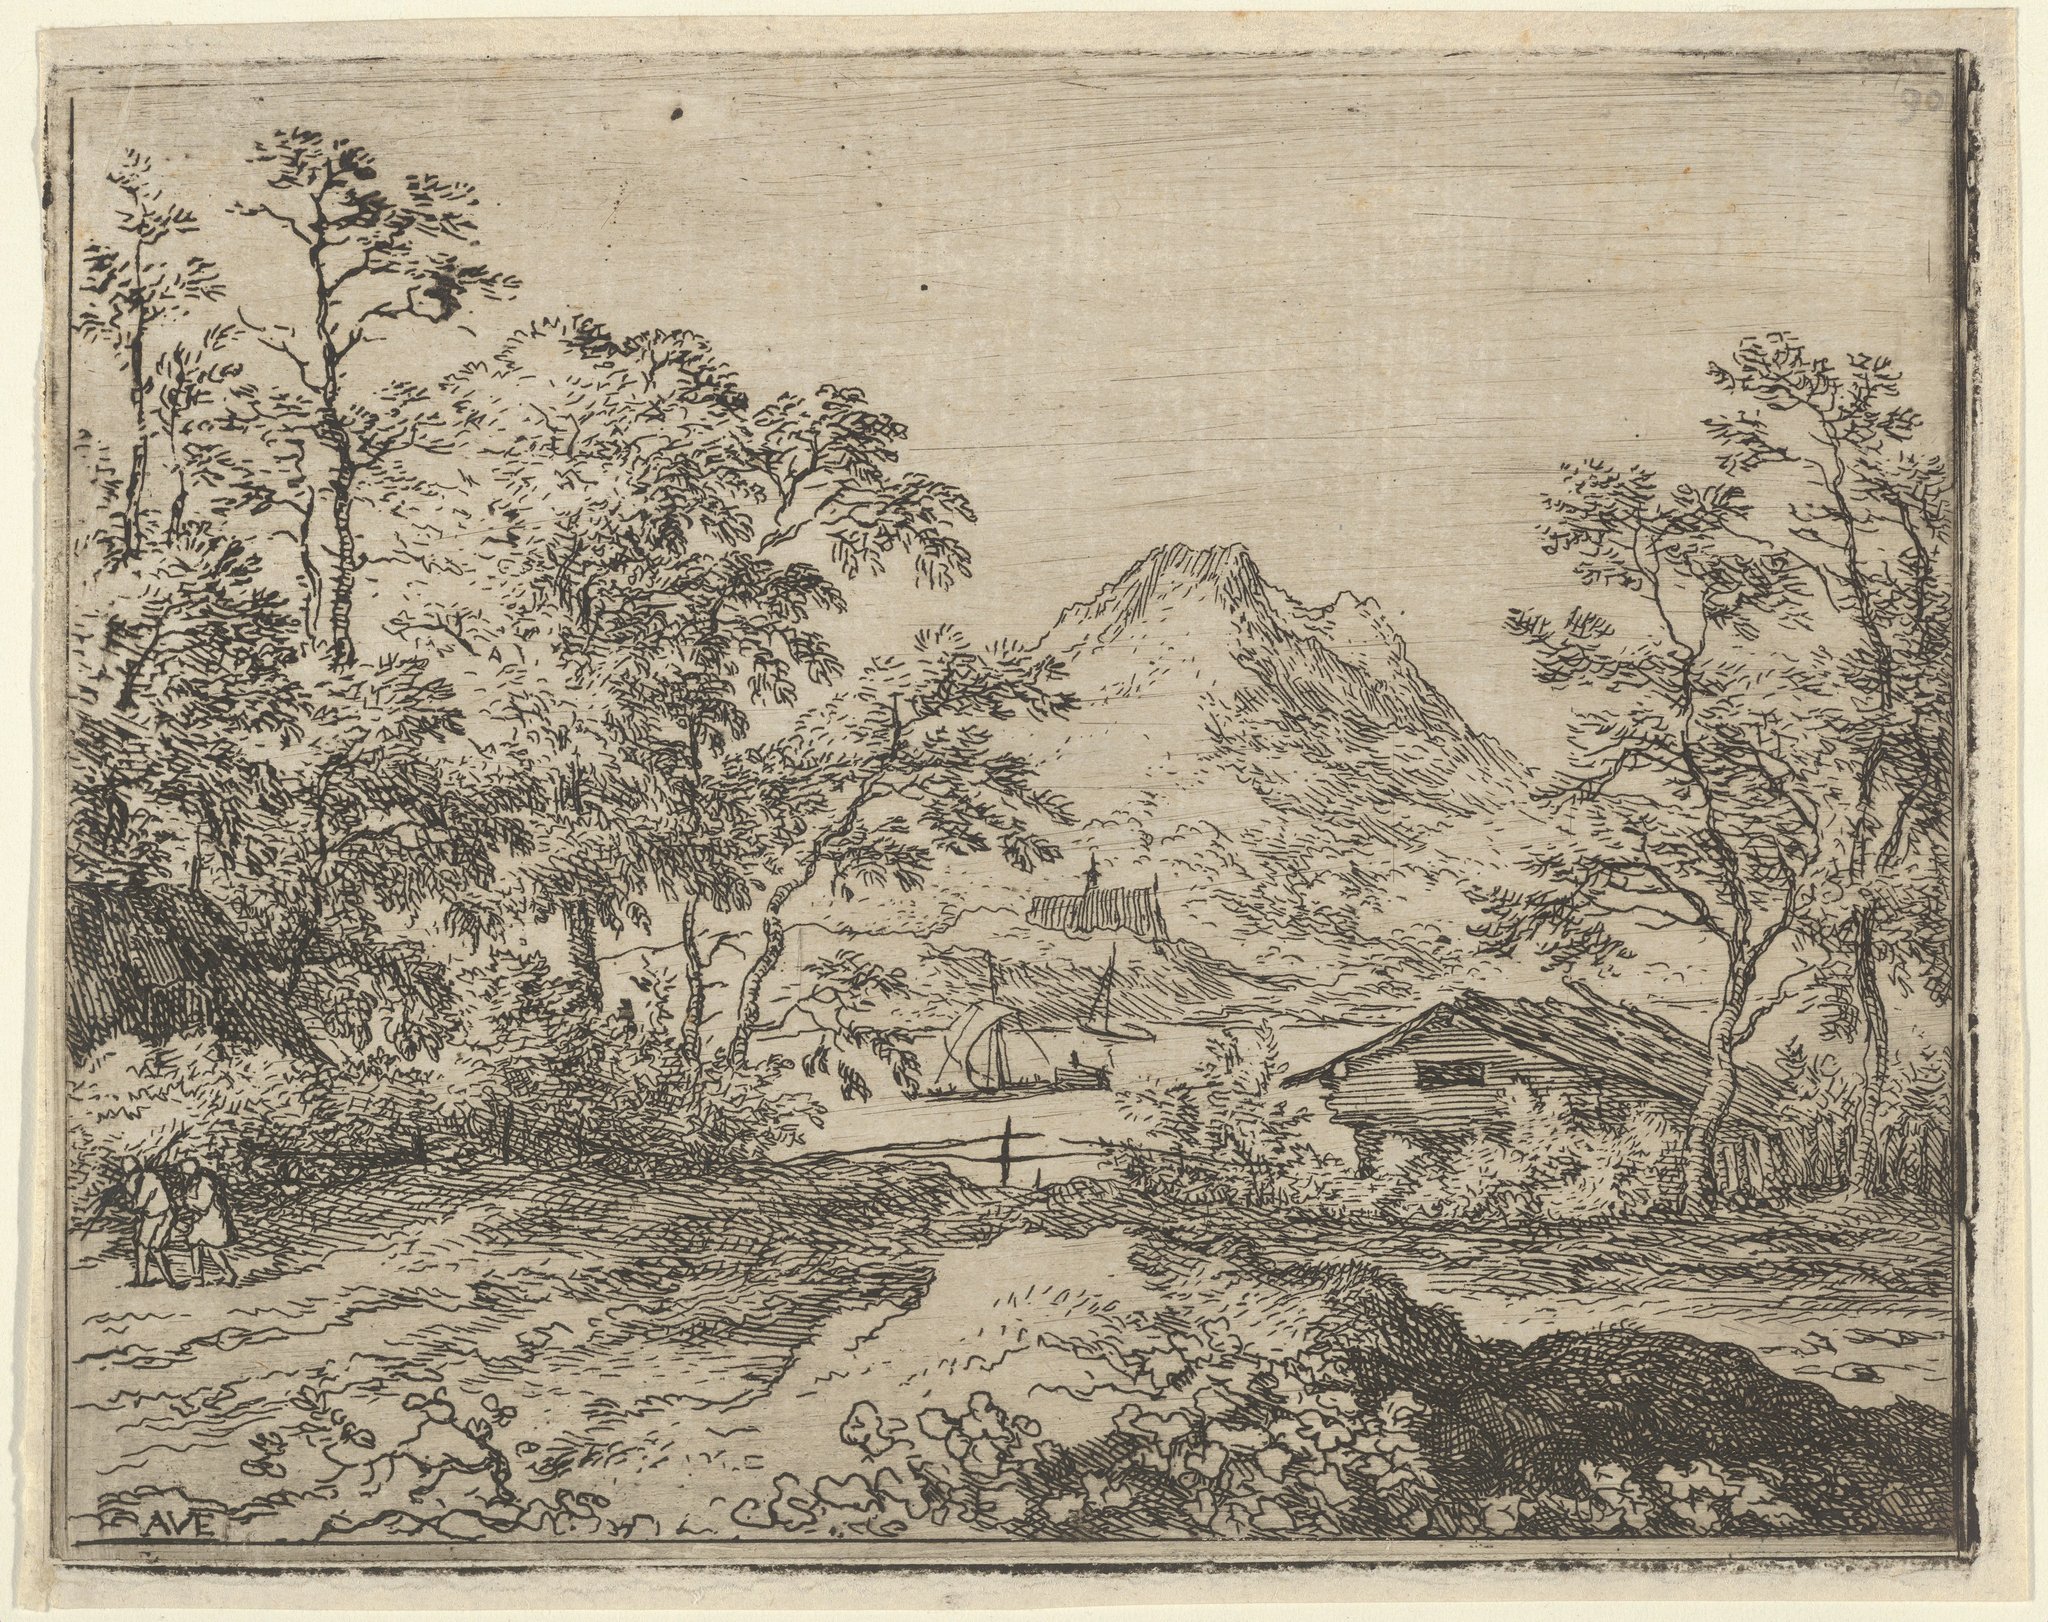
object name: print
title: The Broad River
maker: allart van everdingen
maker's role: artist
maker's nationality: dutch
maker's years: 1621-1675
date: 1621-1675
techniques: engraving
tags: buildings,rivers,mountains,trees,boats